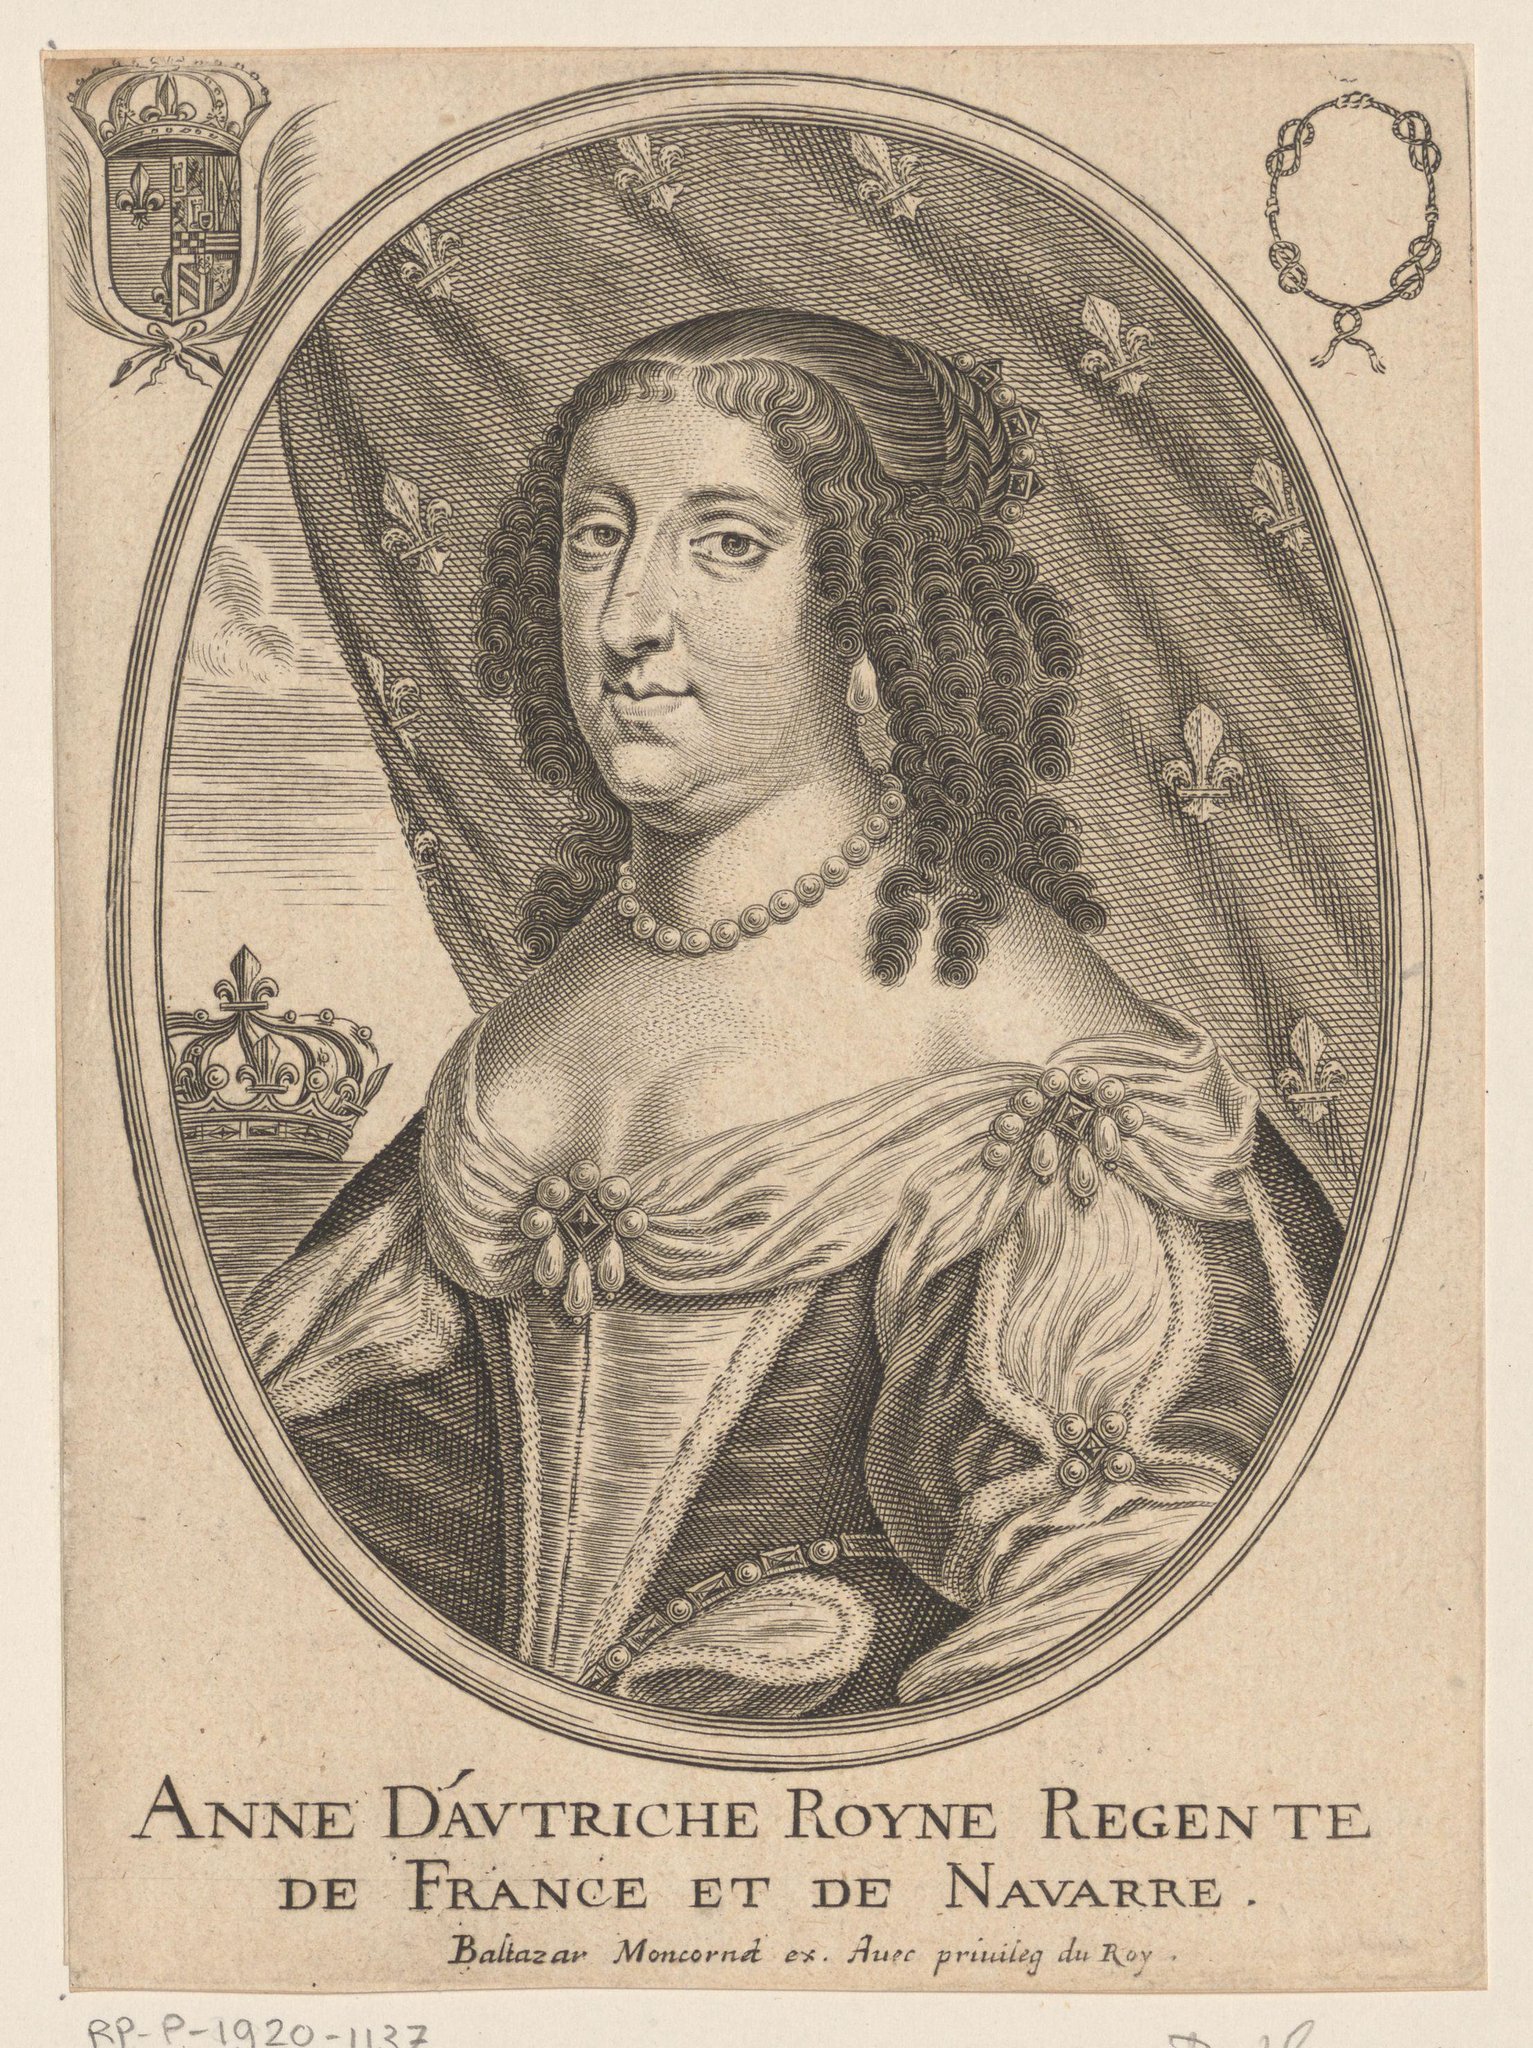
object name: print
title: Portret van Anna van Oostenrijk, koningin van Frankrijk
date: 1643-1668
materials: paper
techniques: engraving, etching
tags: paris, anna van oostenrijk (koningin van frankrijk), historical persons - bb - woman, armorial bearing, heraldry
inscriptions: collector's mark: Lugt 2228